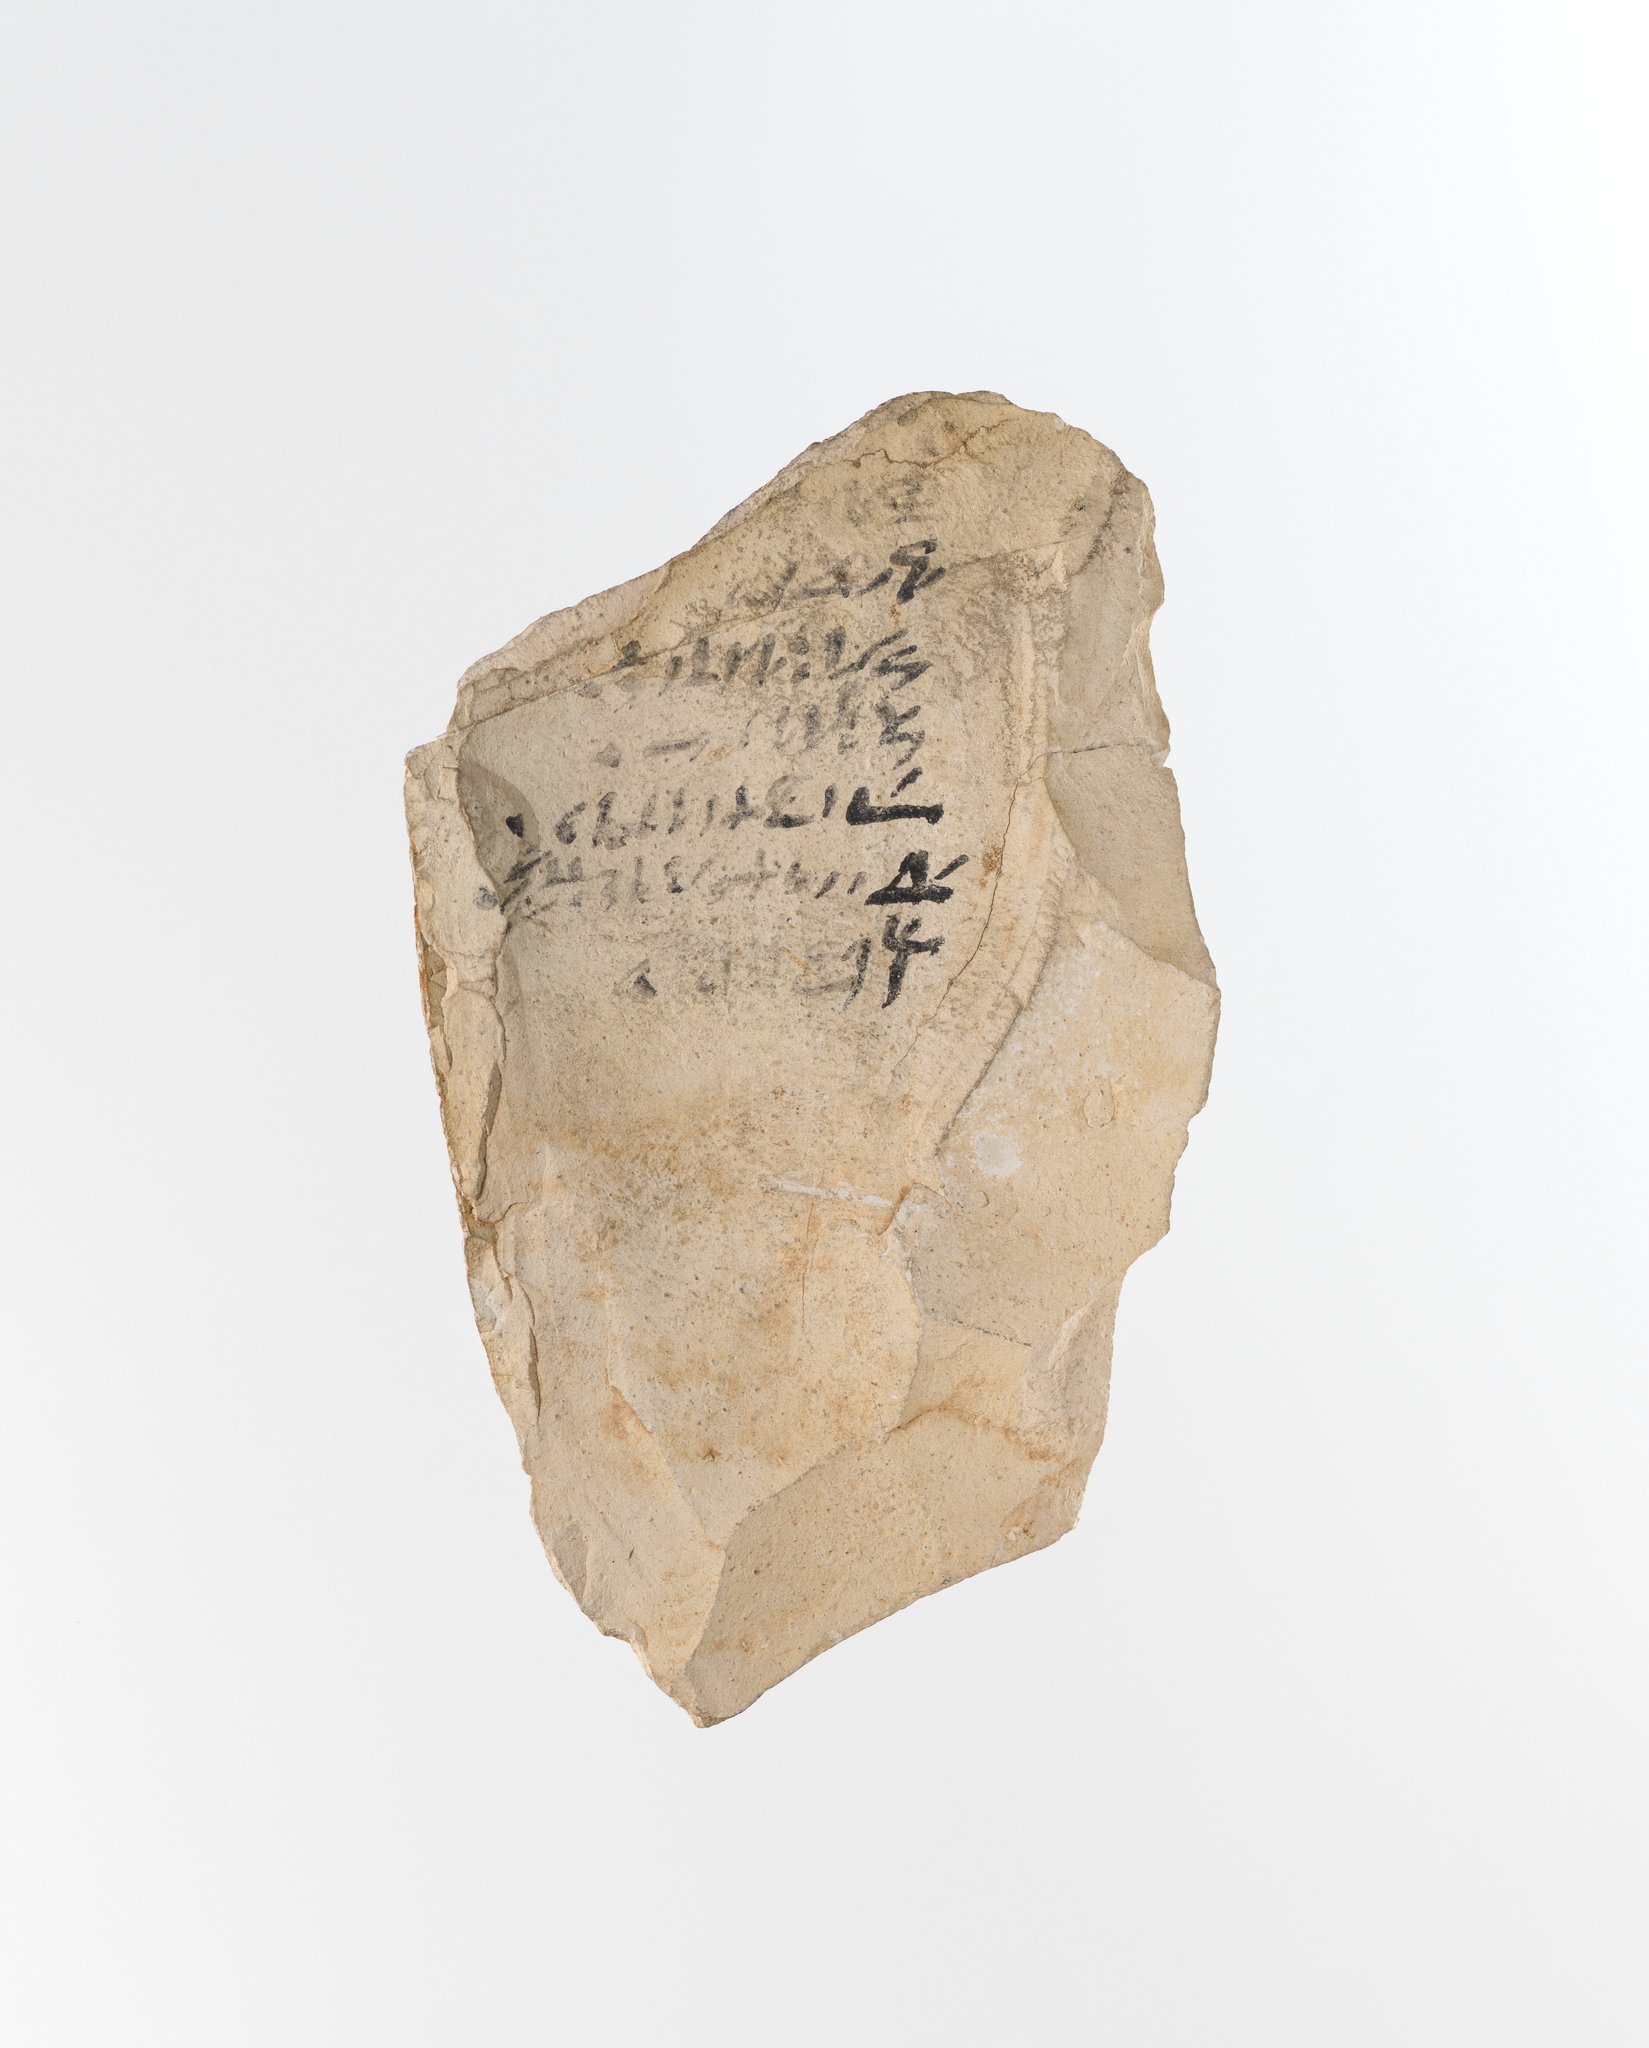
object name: ostracon, hieratic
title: Ostracon with hieratic inscription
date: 1295-525 BCE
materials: ink, limestone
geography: egypt